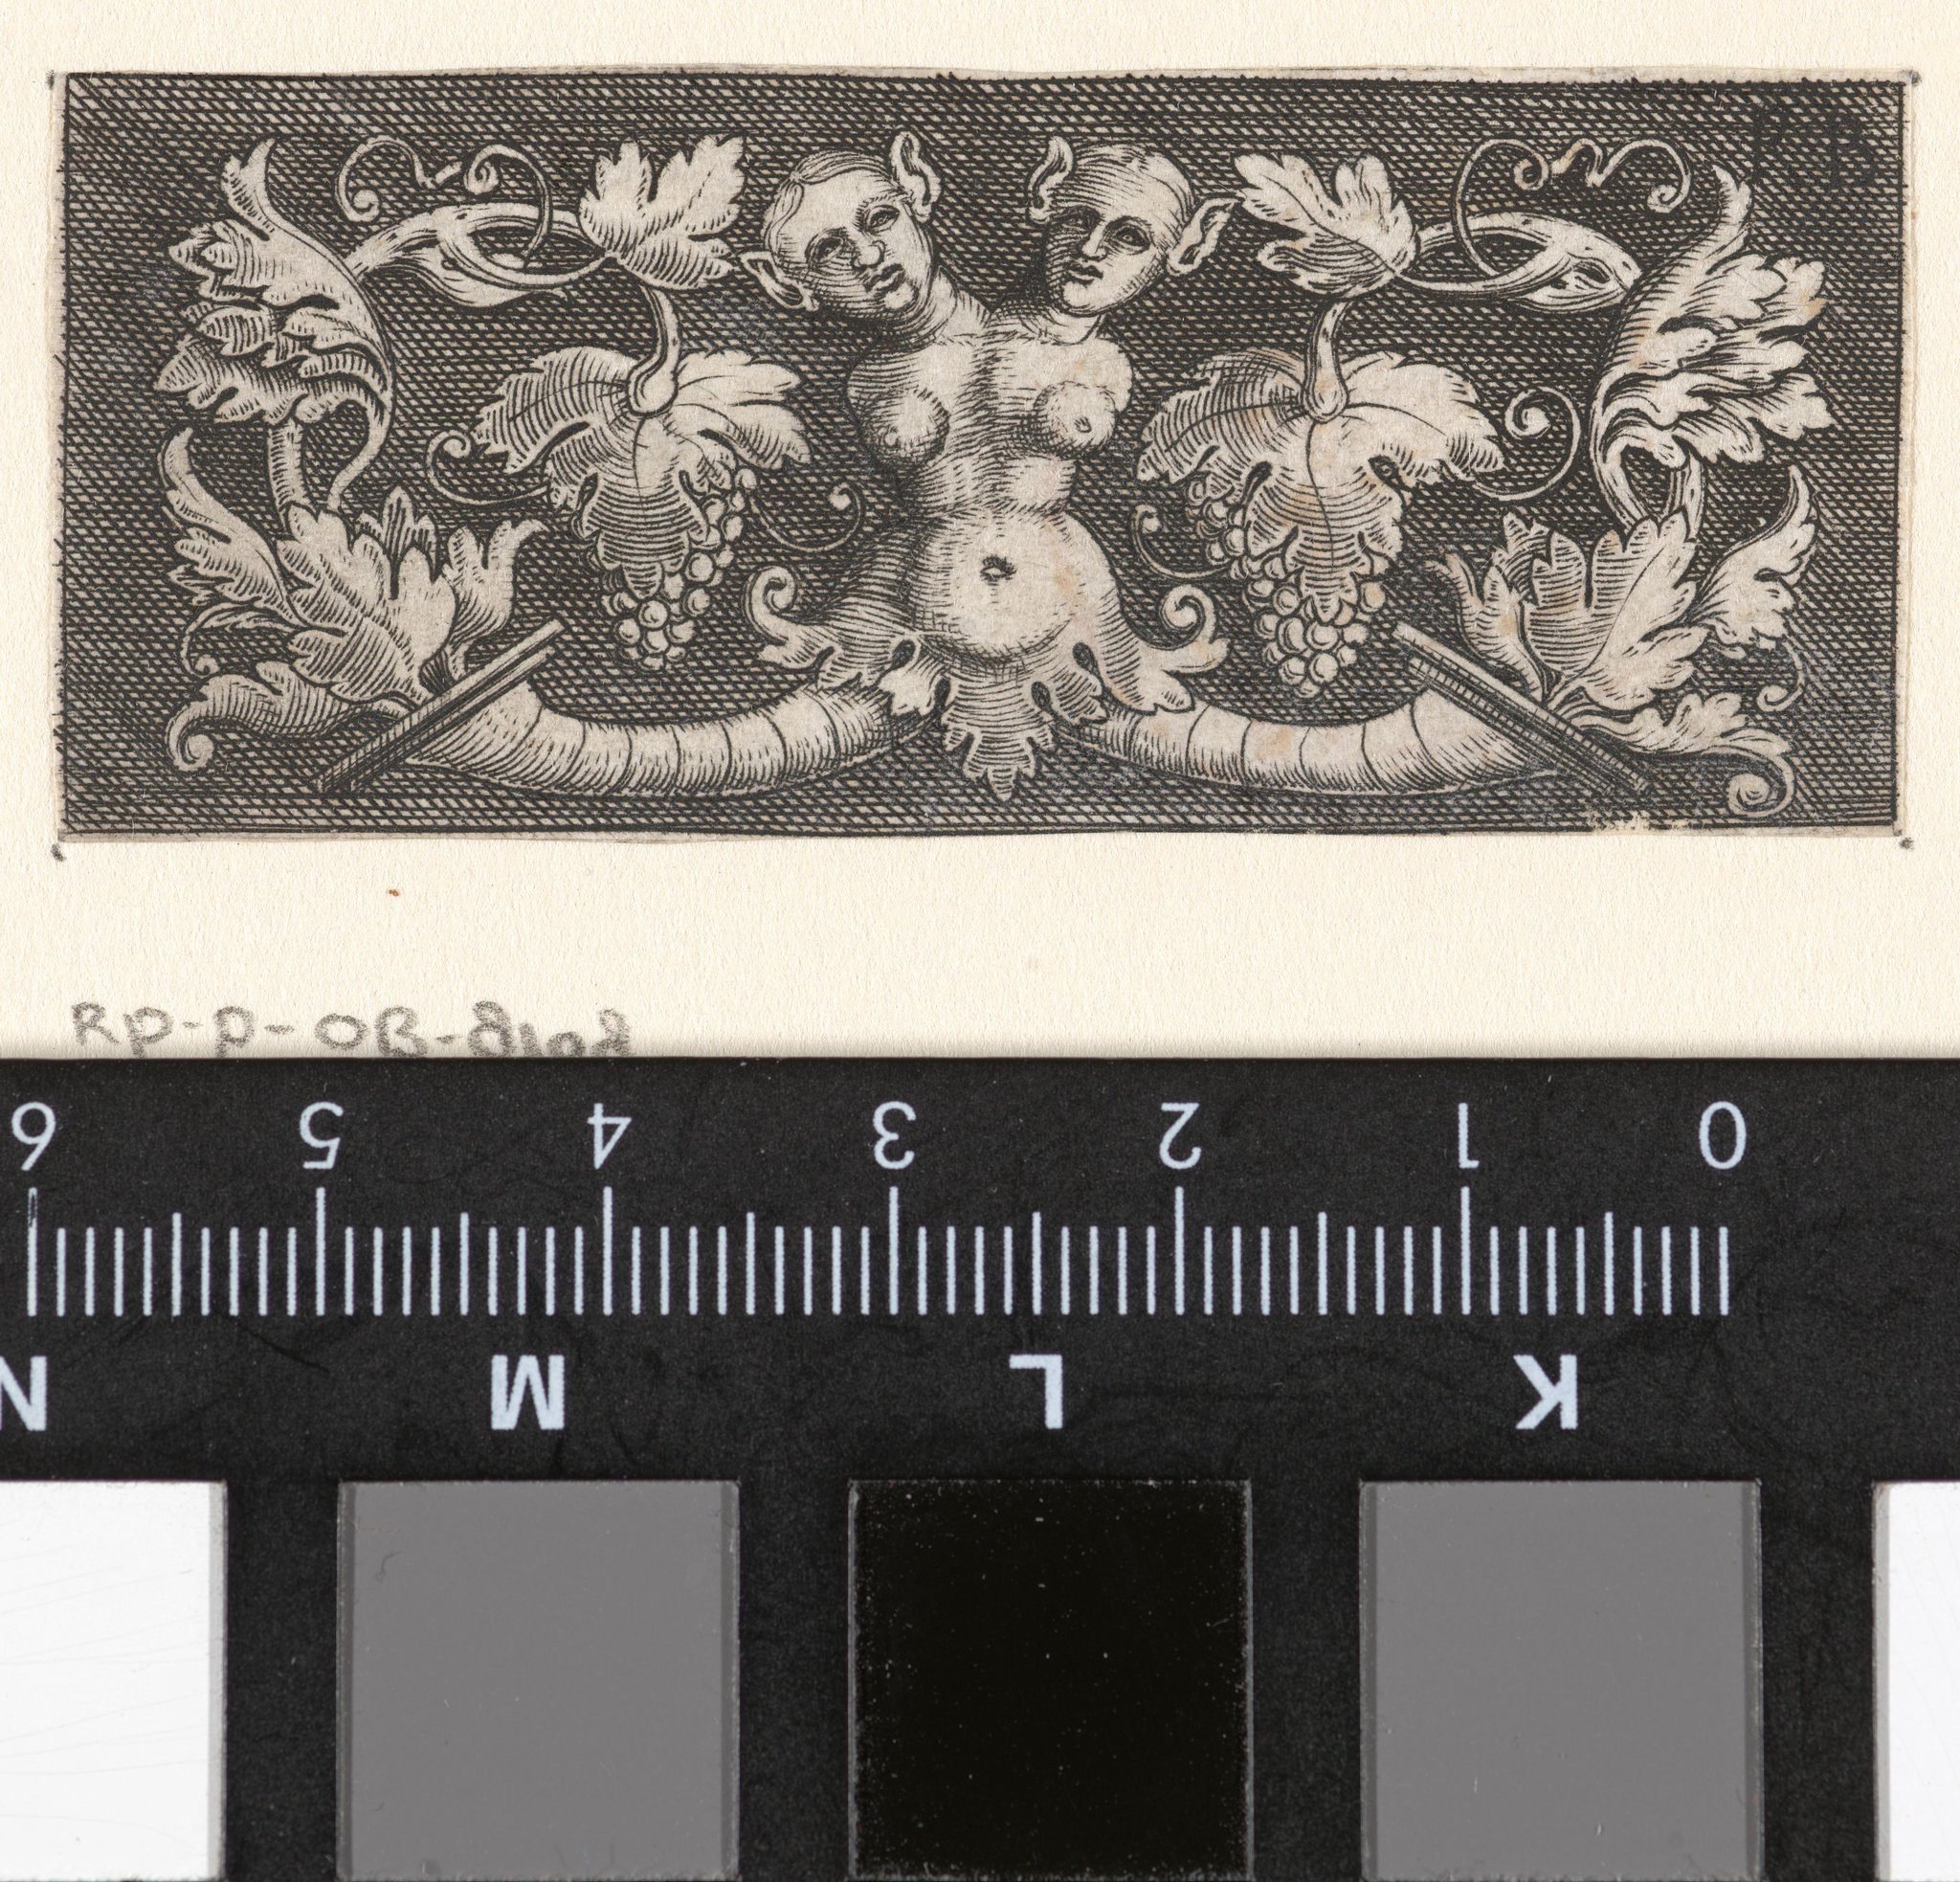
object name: ornament print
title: Fries met in het midden het bovenlichaam van een vrouw met twee hoofden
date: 1500-1600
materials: paper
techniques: engraving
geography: germany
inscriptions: collector's mark: Lugt 240